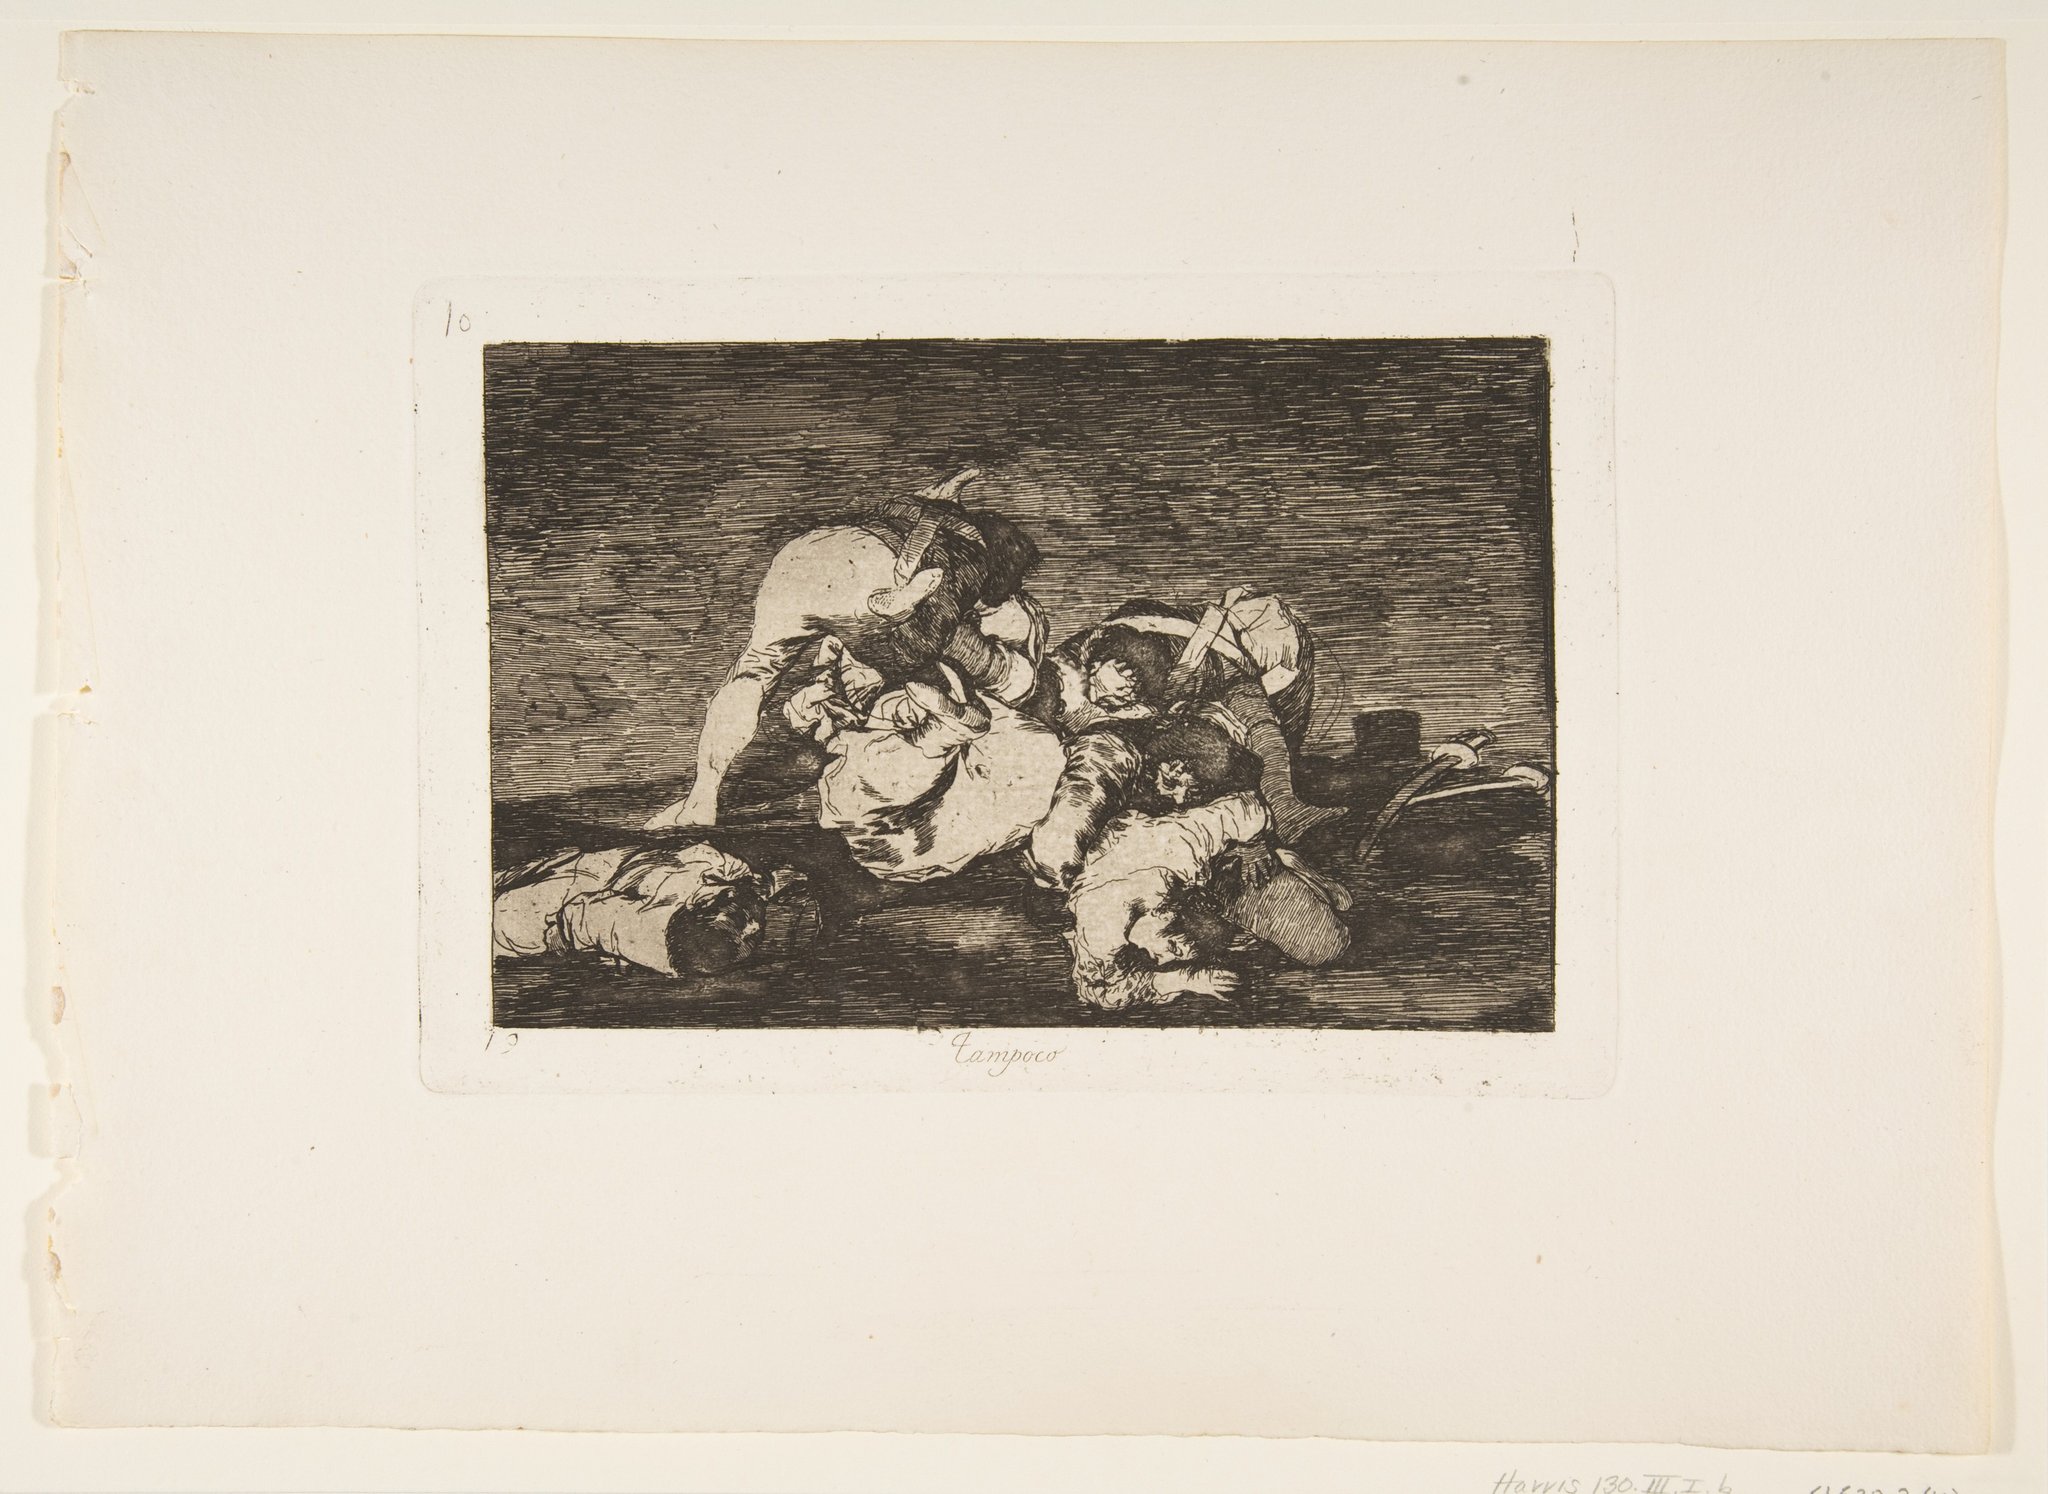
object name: print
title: Plate10 from "The Disasters of War" (Los Desastres de la Guerra): Nor [do these] either (Tampoco)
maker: goya (francisco de goya y lucientes)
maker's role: artist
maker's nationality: spanish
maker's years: 1746-1828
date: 1810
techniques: engraving, etching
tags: human figures,suffering